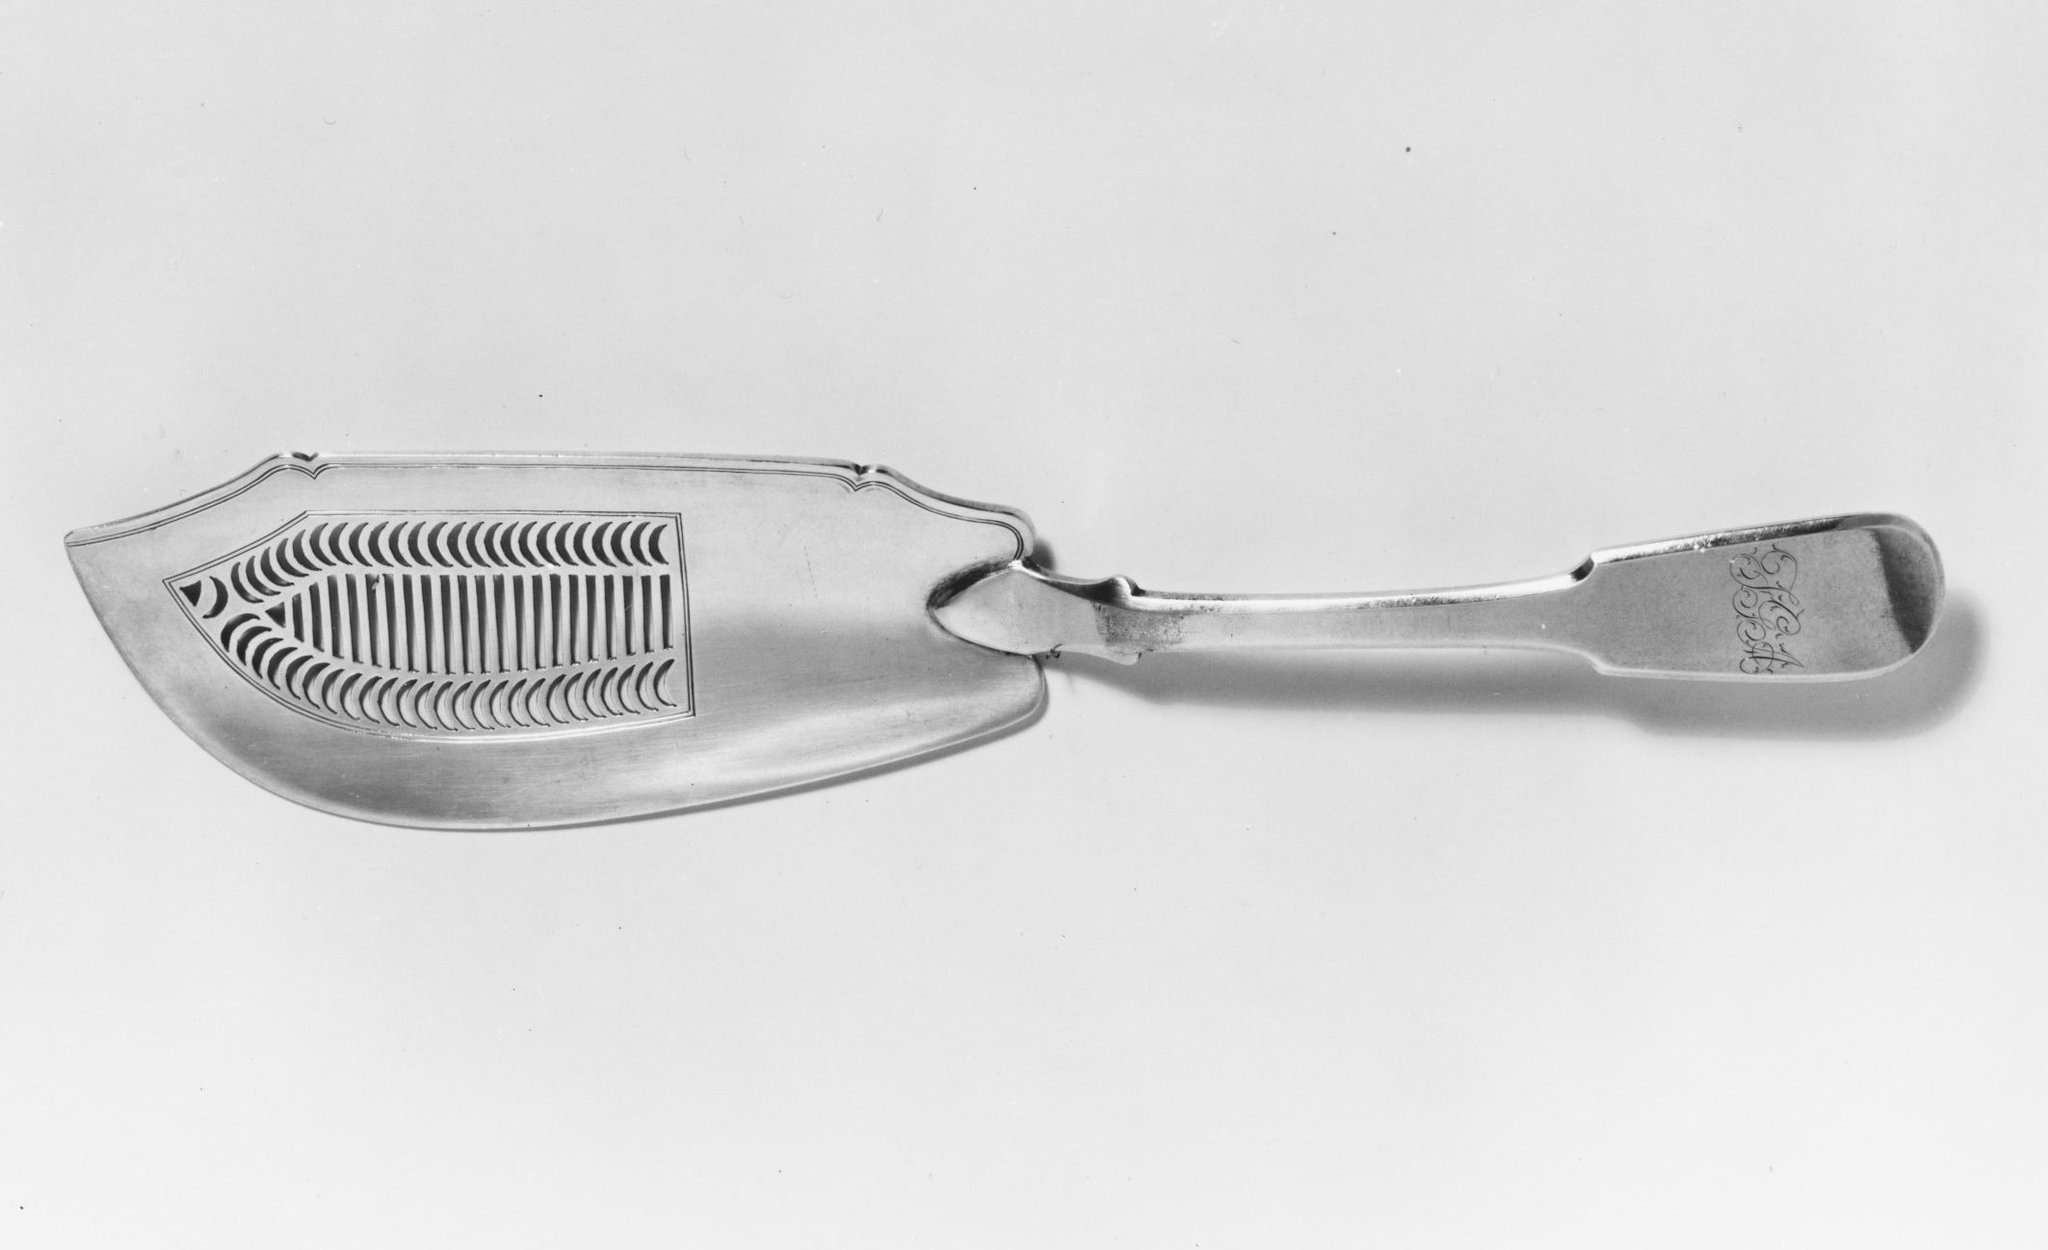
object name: fish slice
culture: american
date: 1800-1900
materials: silver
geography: united states